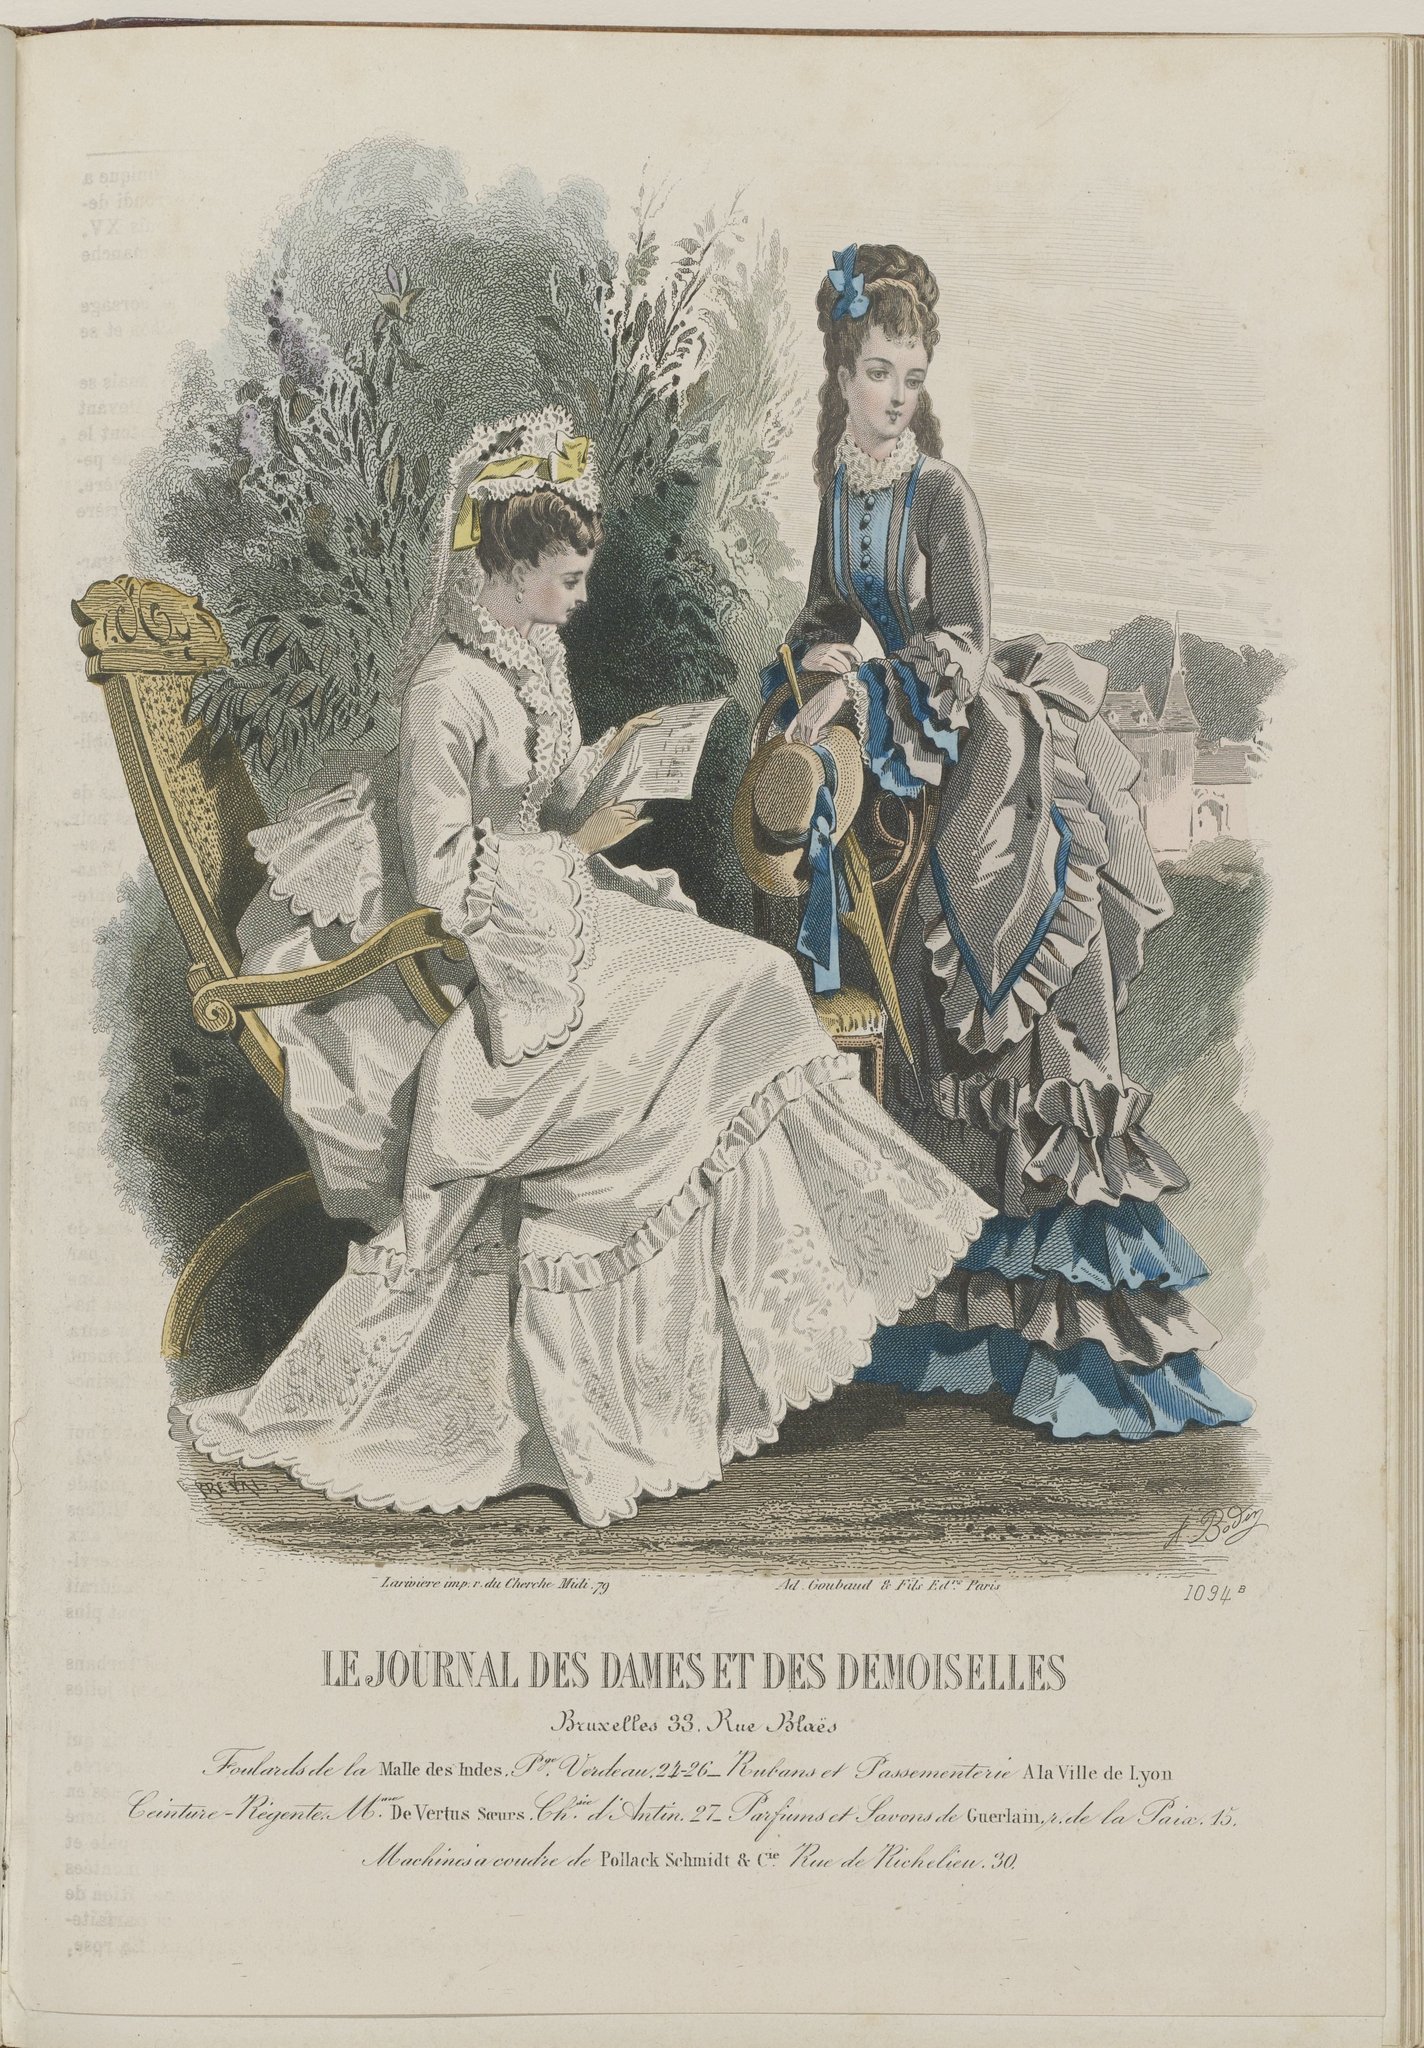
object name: fashion print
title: Journal des Dames et des Demoiselles, 15 Novembre 1872, No. 1094B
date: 1872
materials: paper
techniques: engraving, hand coloring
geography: paris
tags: dress, gown: morning dress (+ women's clothes), head-gear (straw hat) (+ women's clothes), fashion plates, parasol, sunshade (+ women's clothes)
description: Japonnen voor de vakantie op het platteland. Links een een witte ochtendjapon met casaque. Rechts een japon van grijze en blauwe foulard, met casaque in de stijl van Lodewijk XV. Strohoedje en parasol in de hand. In onderschrift enkele adressen voor stoffen, accessoires en andere producten. Prent uit Le Journal des Dames et des Demoiselles (1841-1902).